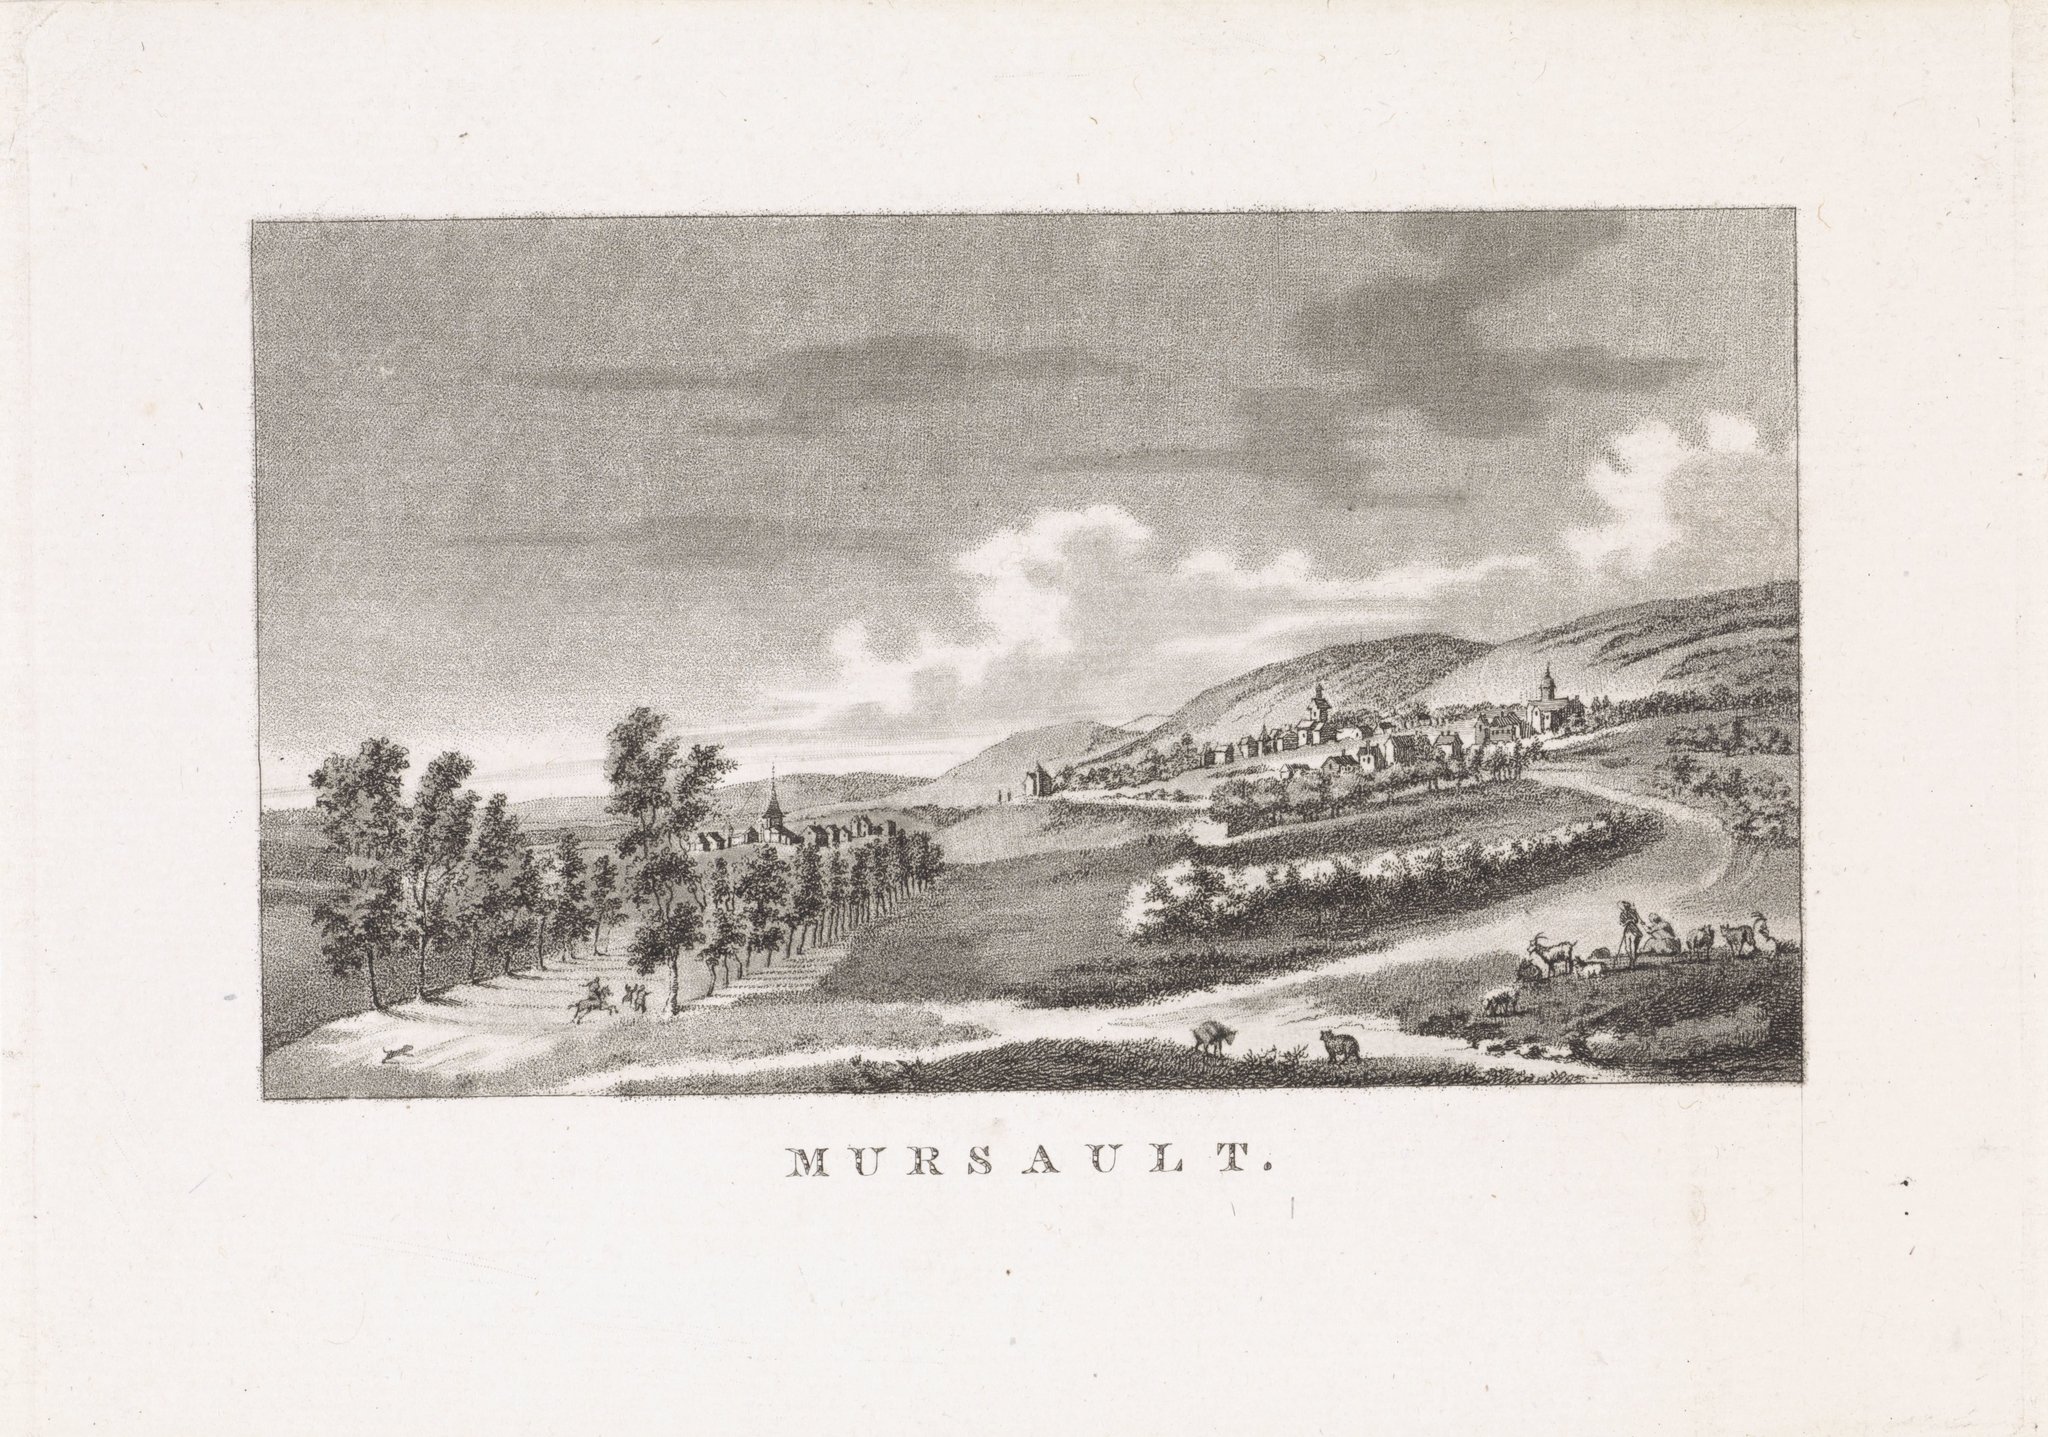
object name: print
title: Mursault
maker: daniël veelwaard (i)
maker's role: print maker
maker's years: 1766-1851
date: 1776-1851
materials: paper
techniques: etching, roulette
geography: amsterdam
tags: low hill country, prospect of city, town panorama, silhouette of city (+ city(-scape) with figures, staffage)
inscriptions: collector's mark: Lugt 2228